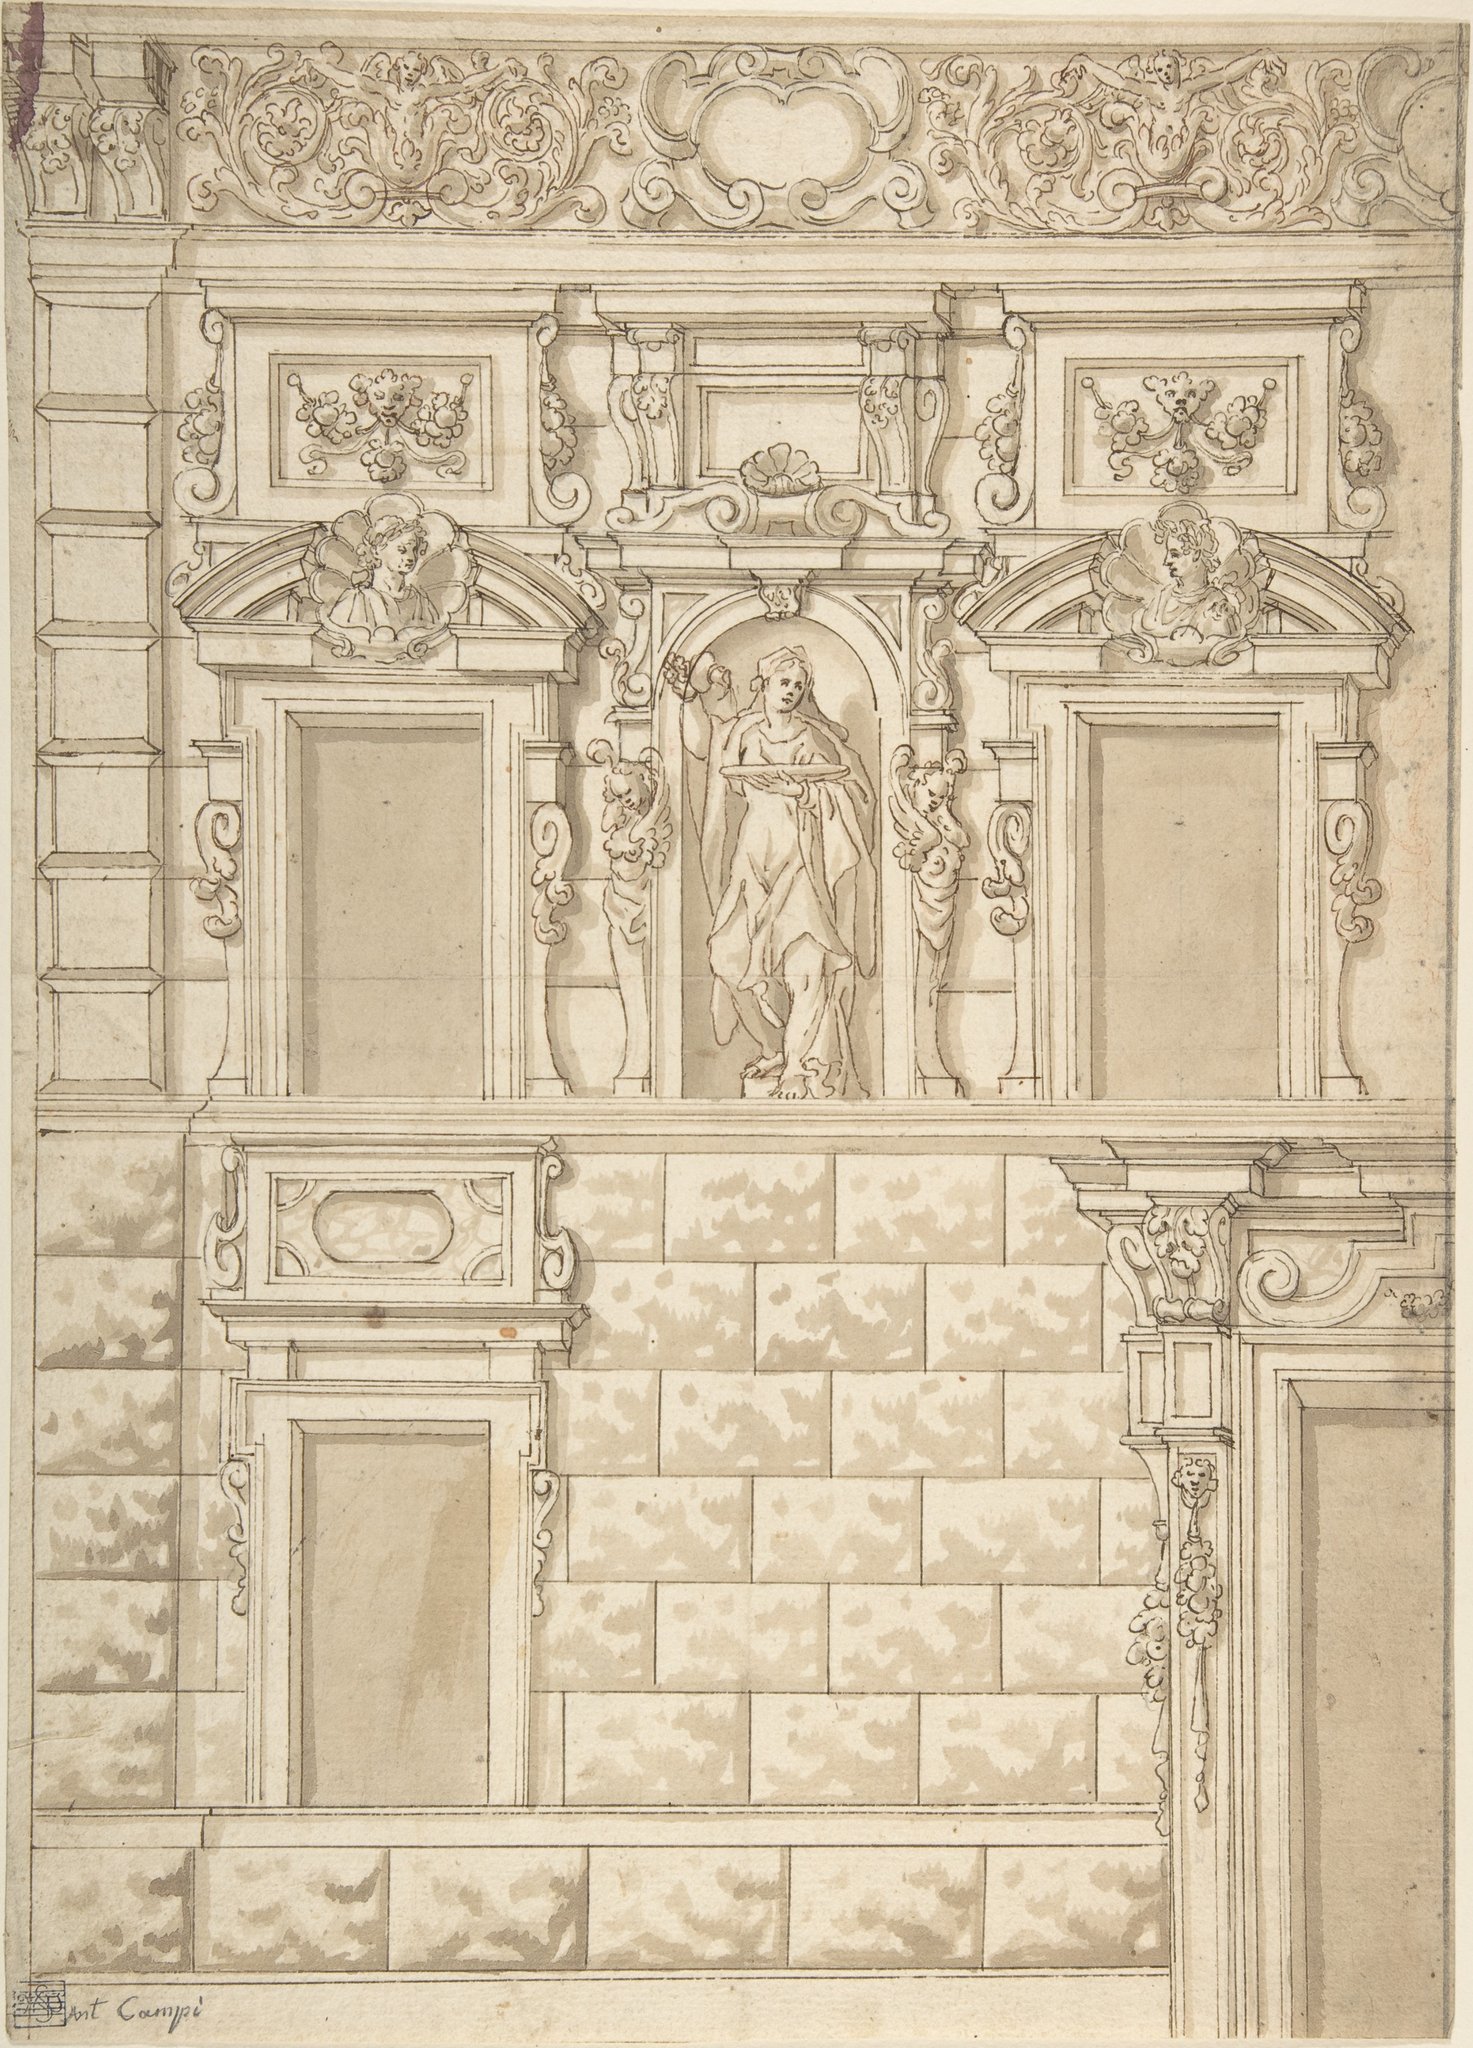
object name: drawing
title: Design for a Façade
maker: anonymous, italian, 18th century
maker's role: artist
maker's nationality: italian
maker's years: 1700-1800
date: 1701-1800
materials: ink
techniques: brush, pen, wash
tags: architecture,ornament